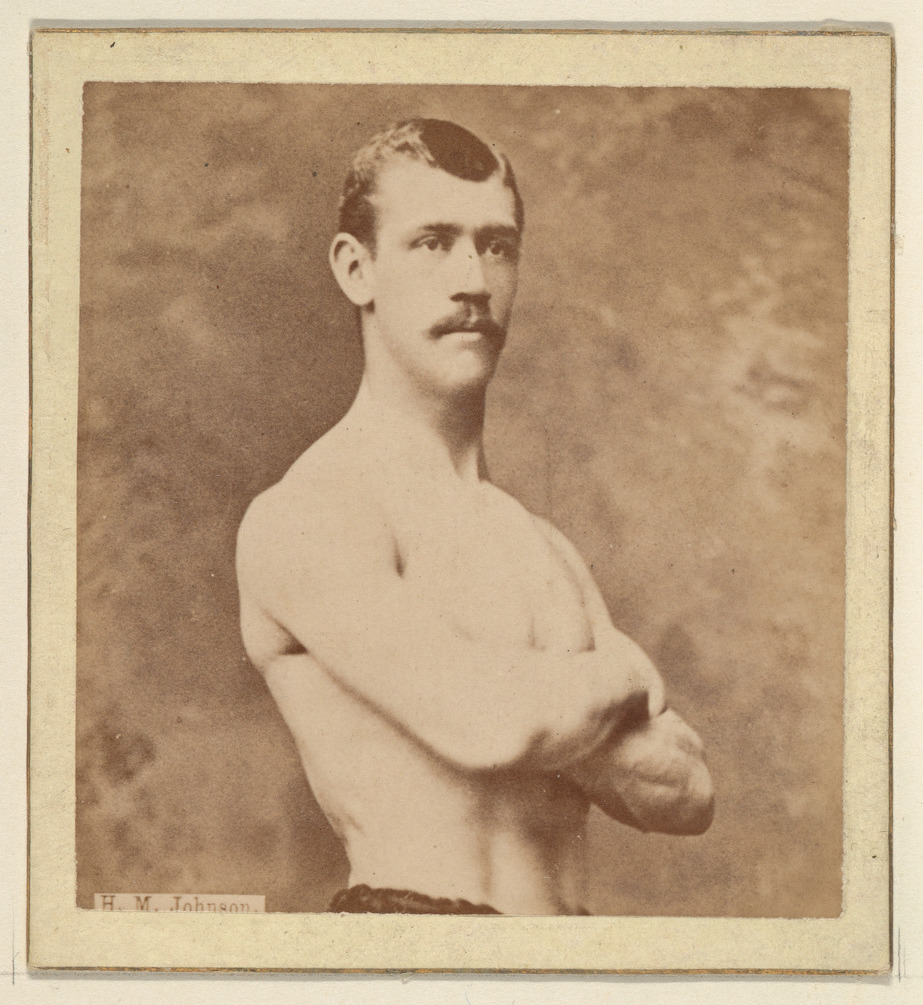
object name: photograph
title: H.M. Johnson, from the Actresses series (N246), Type 2, issued by Kinney Brothers to promote Sporting Extra Cigarettes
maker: kinney brothers tobacco company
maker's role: publisher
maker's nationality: american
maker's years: 1869-2011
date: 1890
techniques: albumen silver print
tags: men,portraits,actors